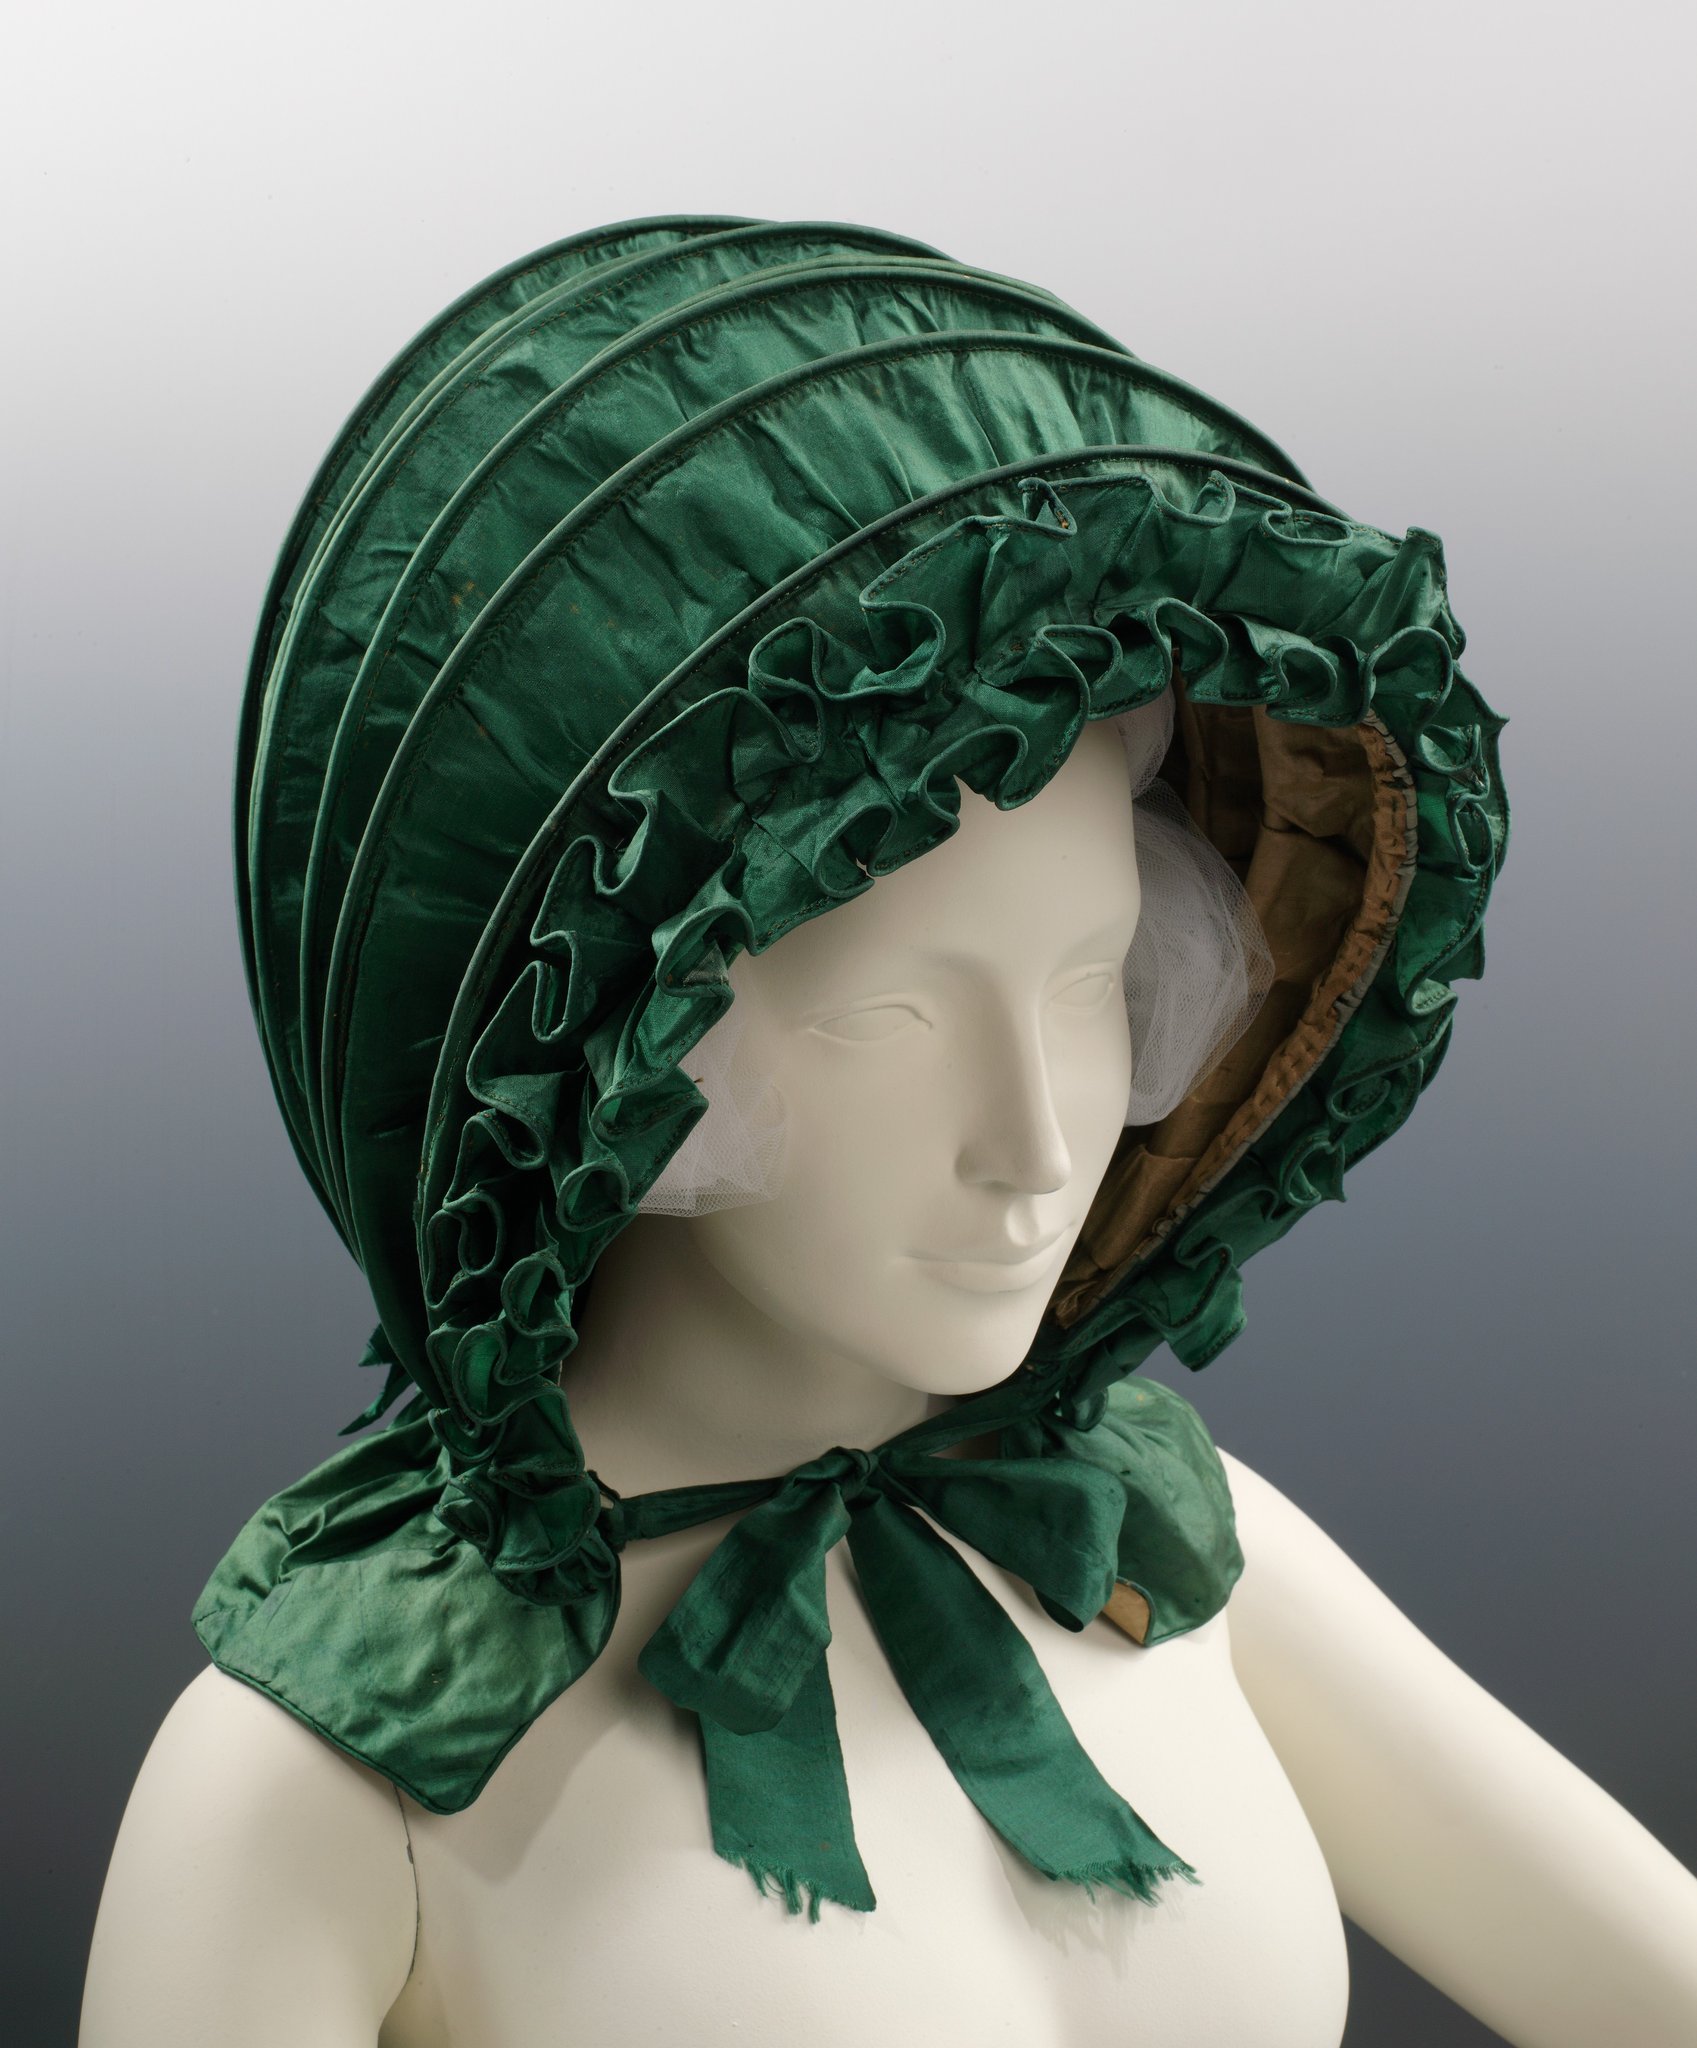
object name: calash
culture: american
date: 1820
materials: silk